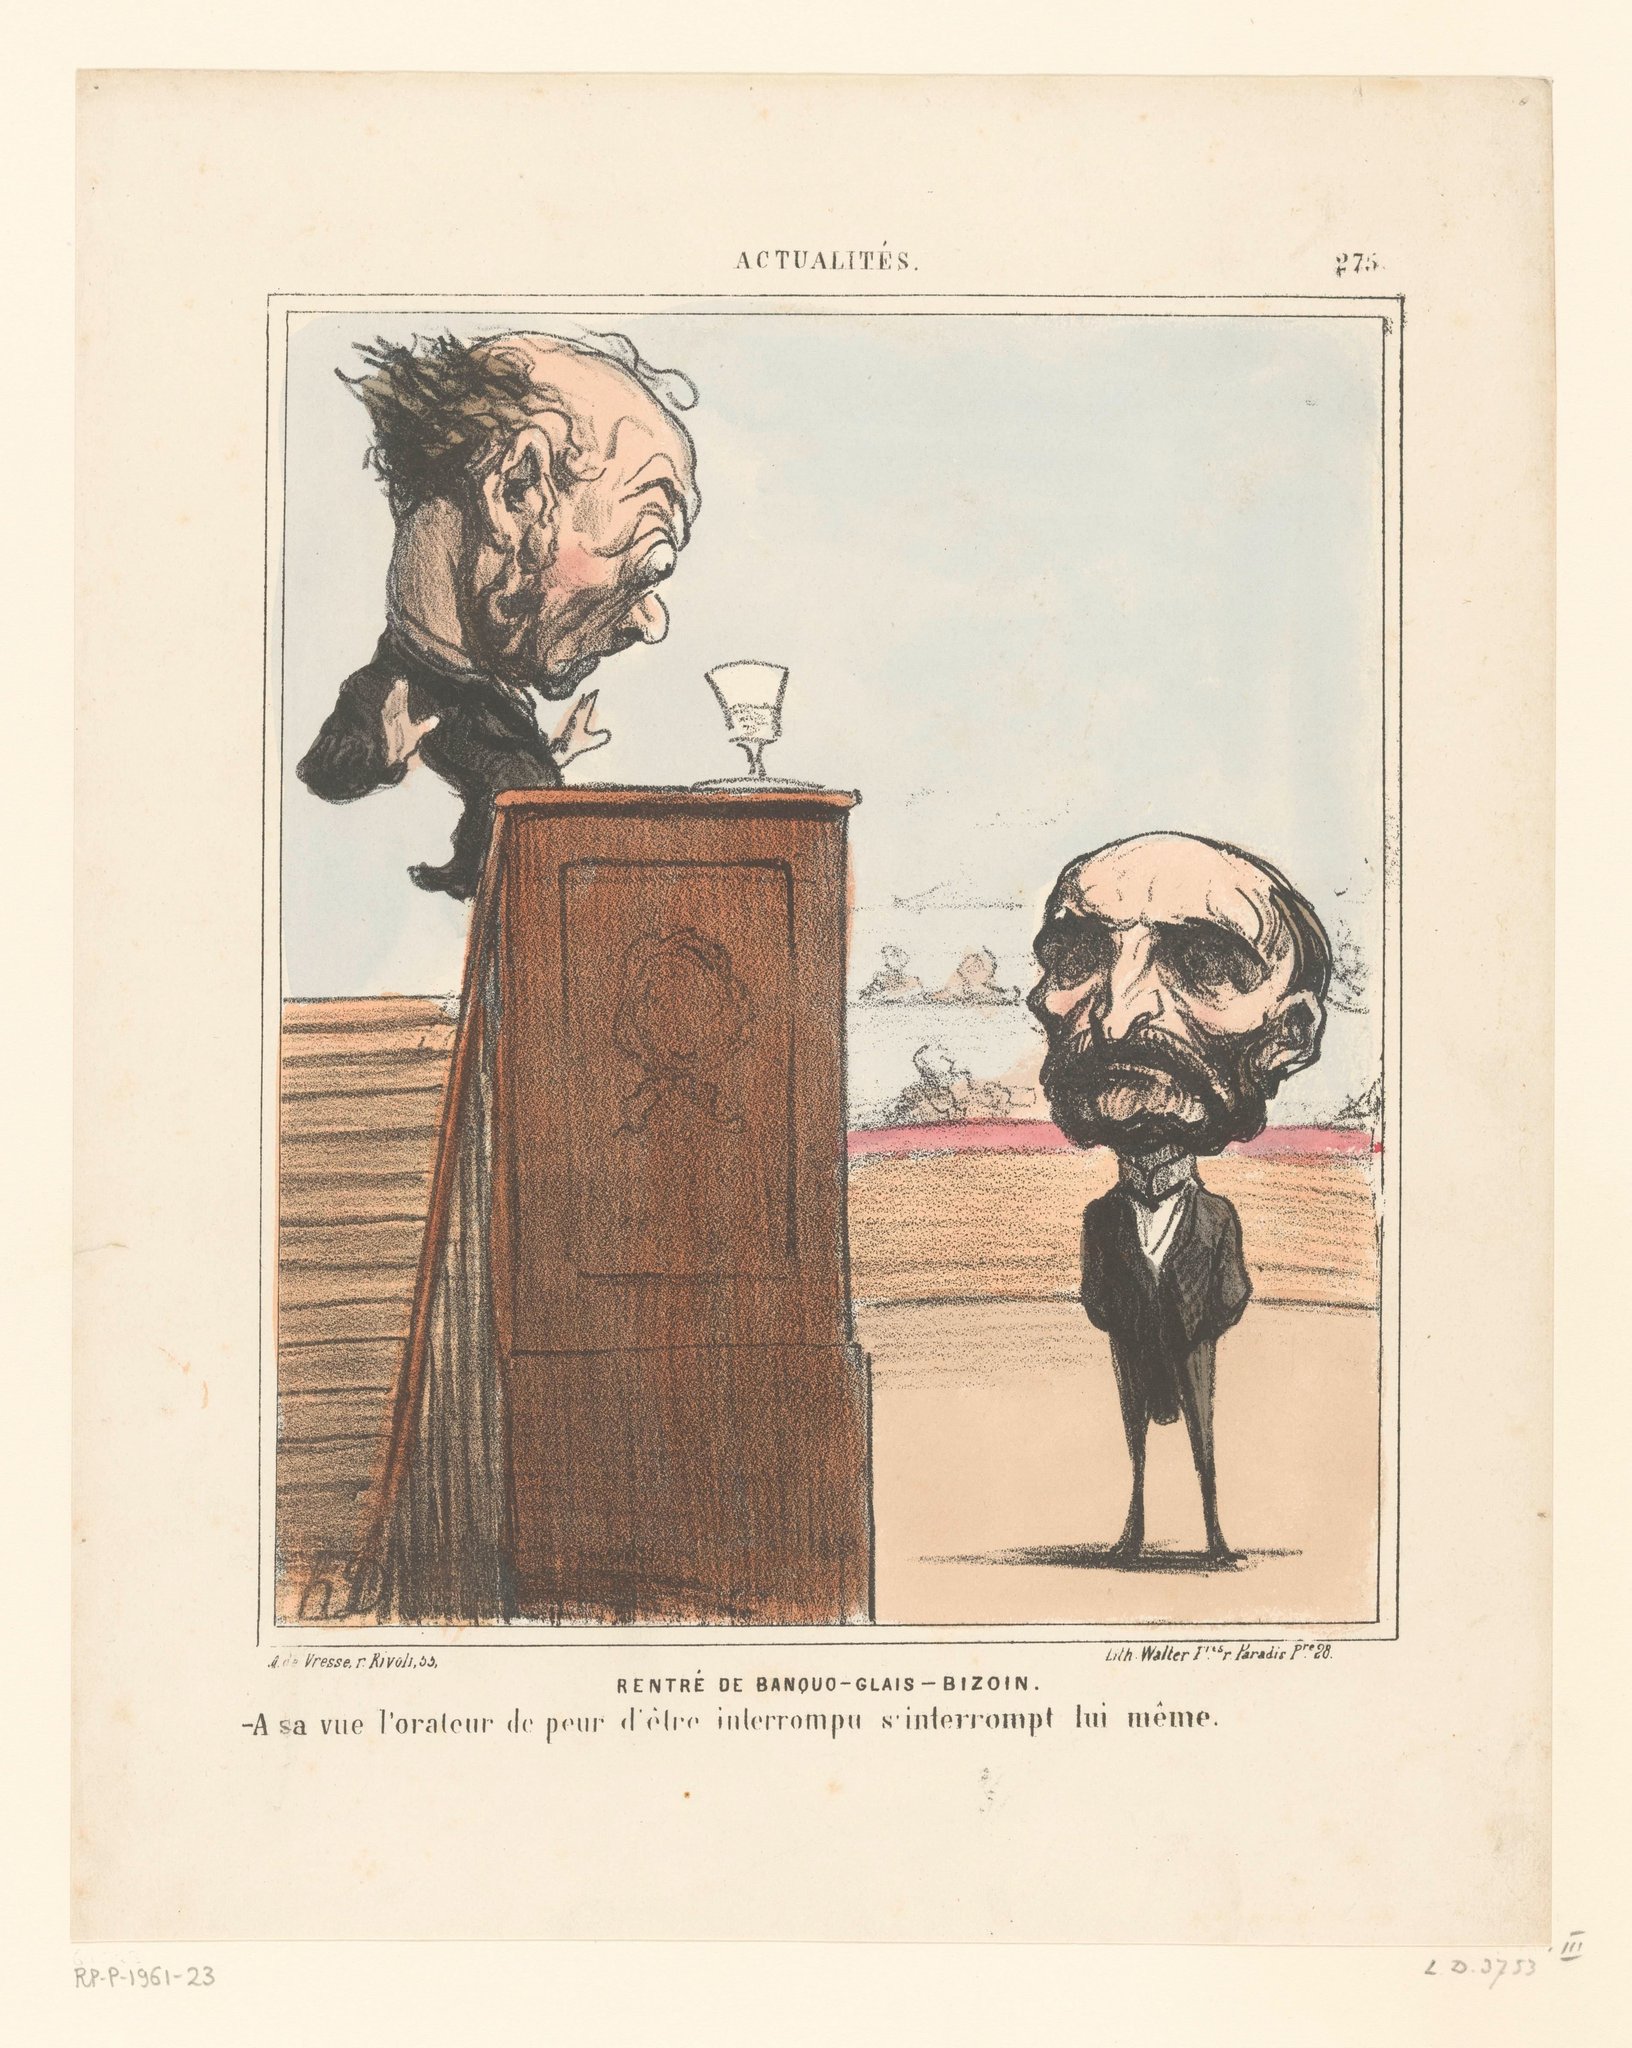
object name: cartoon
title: Actualiteiten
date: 1869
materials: paper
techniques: hand coloring, lithograph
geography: paris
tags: caricatures (human types), politics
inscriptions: collector's mark: Lugt 2760, collector's mark: Lugt 2228a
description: Prent gebruikt voor: Le Charivari, 14 december 1869.